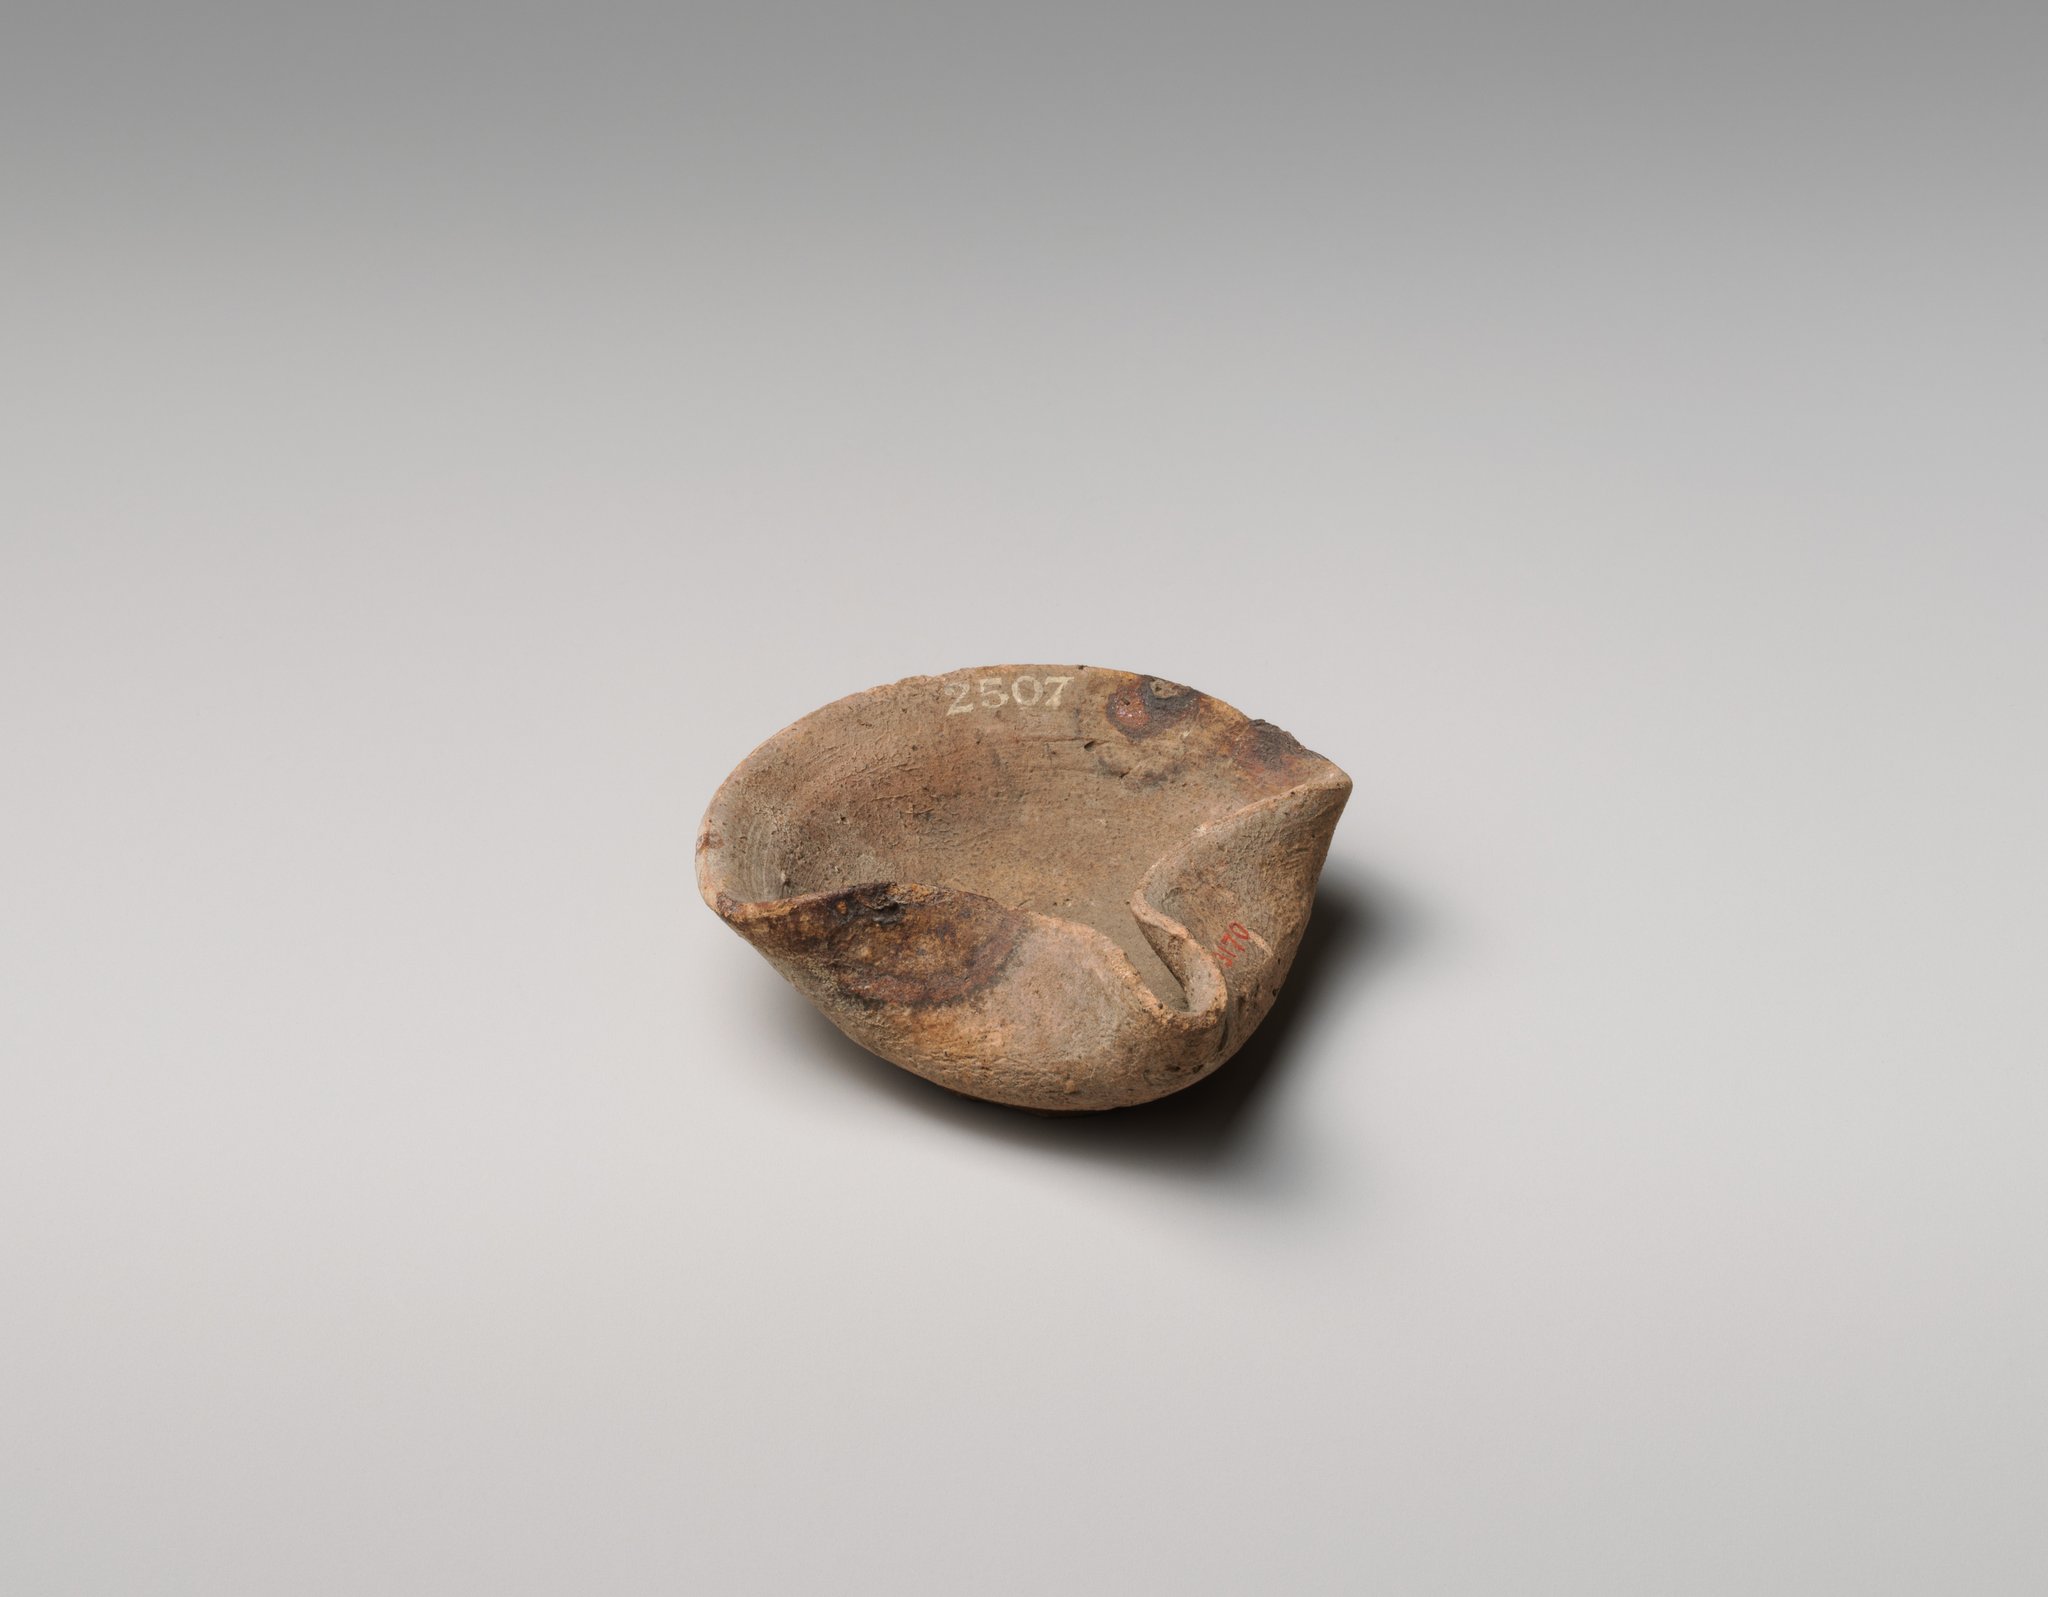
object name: lamp, saucer shaped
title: Terracotta saucer-shaped lamp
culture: cypriot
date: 400-301 BCE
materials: terracotta